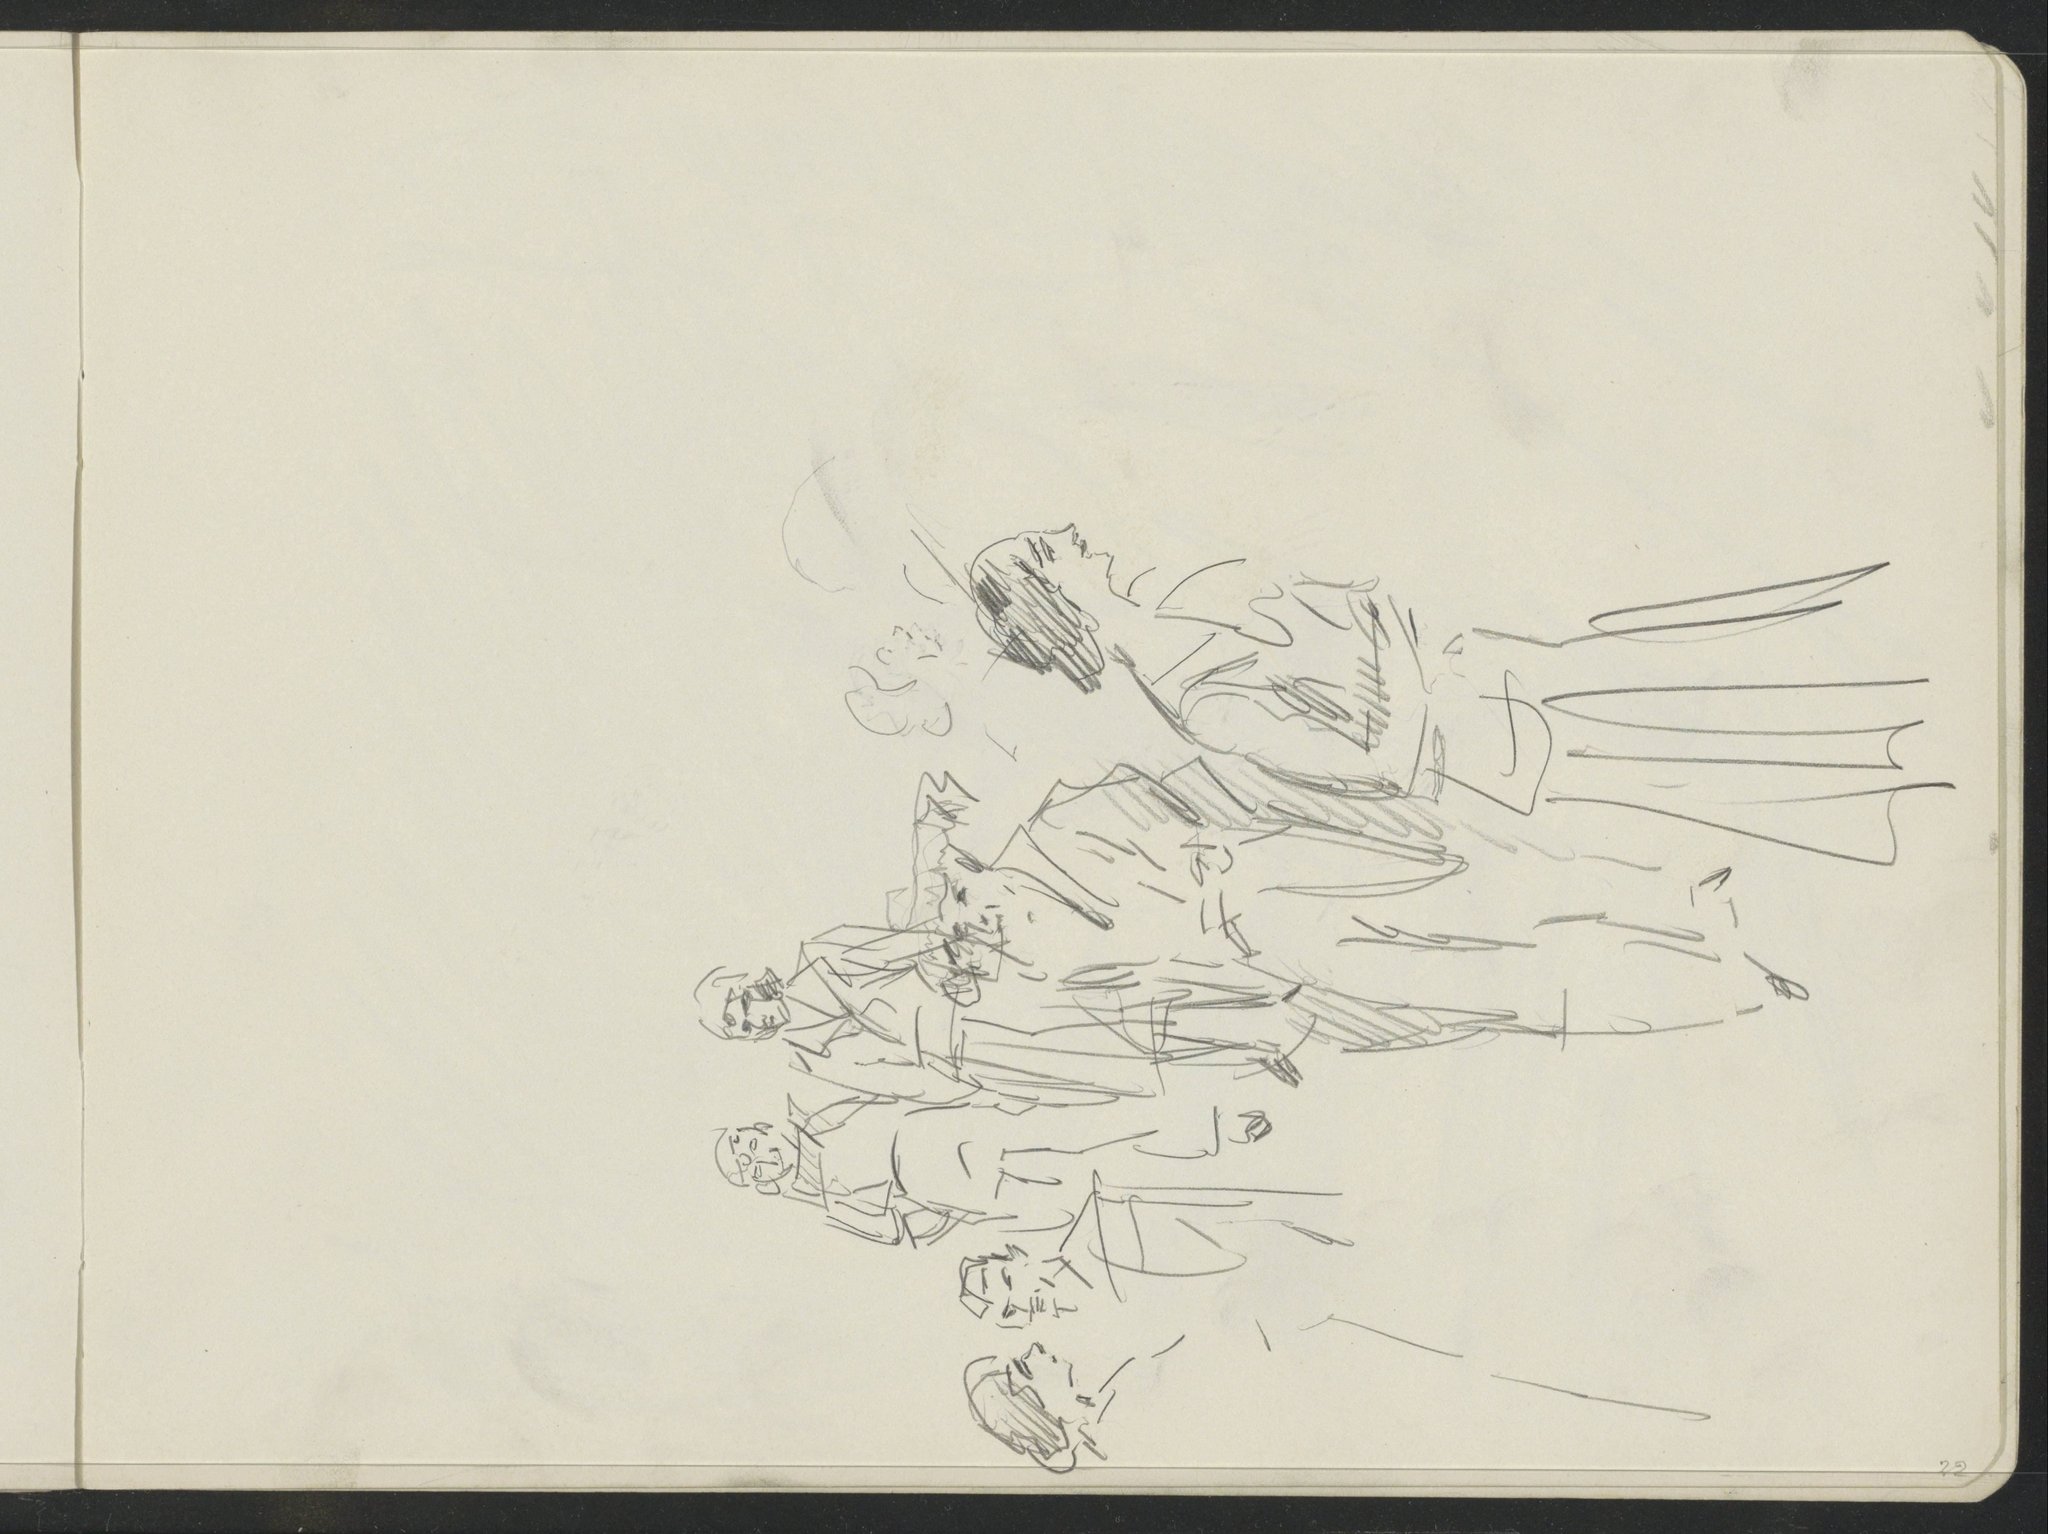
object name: sketchbook leaf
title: Mannen en vrouwen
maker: isaac israels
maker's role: draughtsman, painter, print maker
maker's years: 1865-1934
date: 1915-1934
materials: paper, pencil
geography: the hague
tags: adult woman, stage costume, adult man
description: Mogelijk deels verkleed. Blad 22 recto uit schetsboek XVII met 31 bladen.